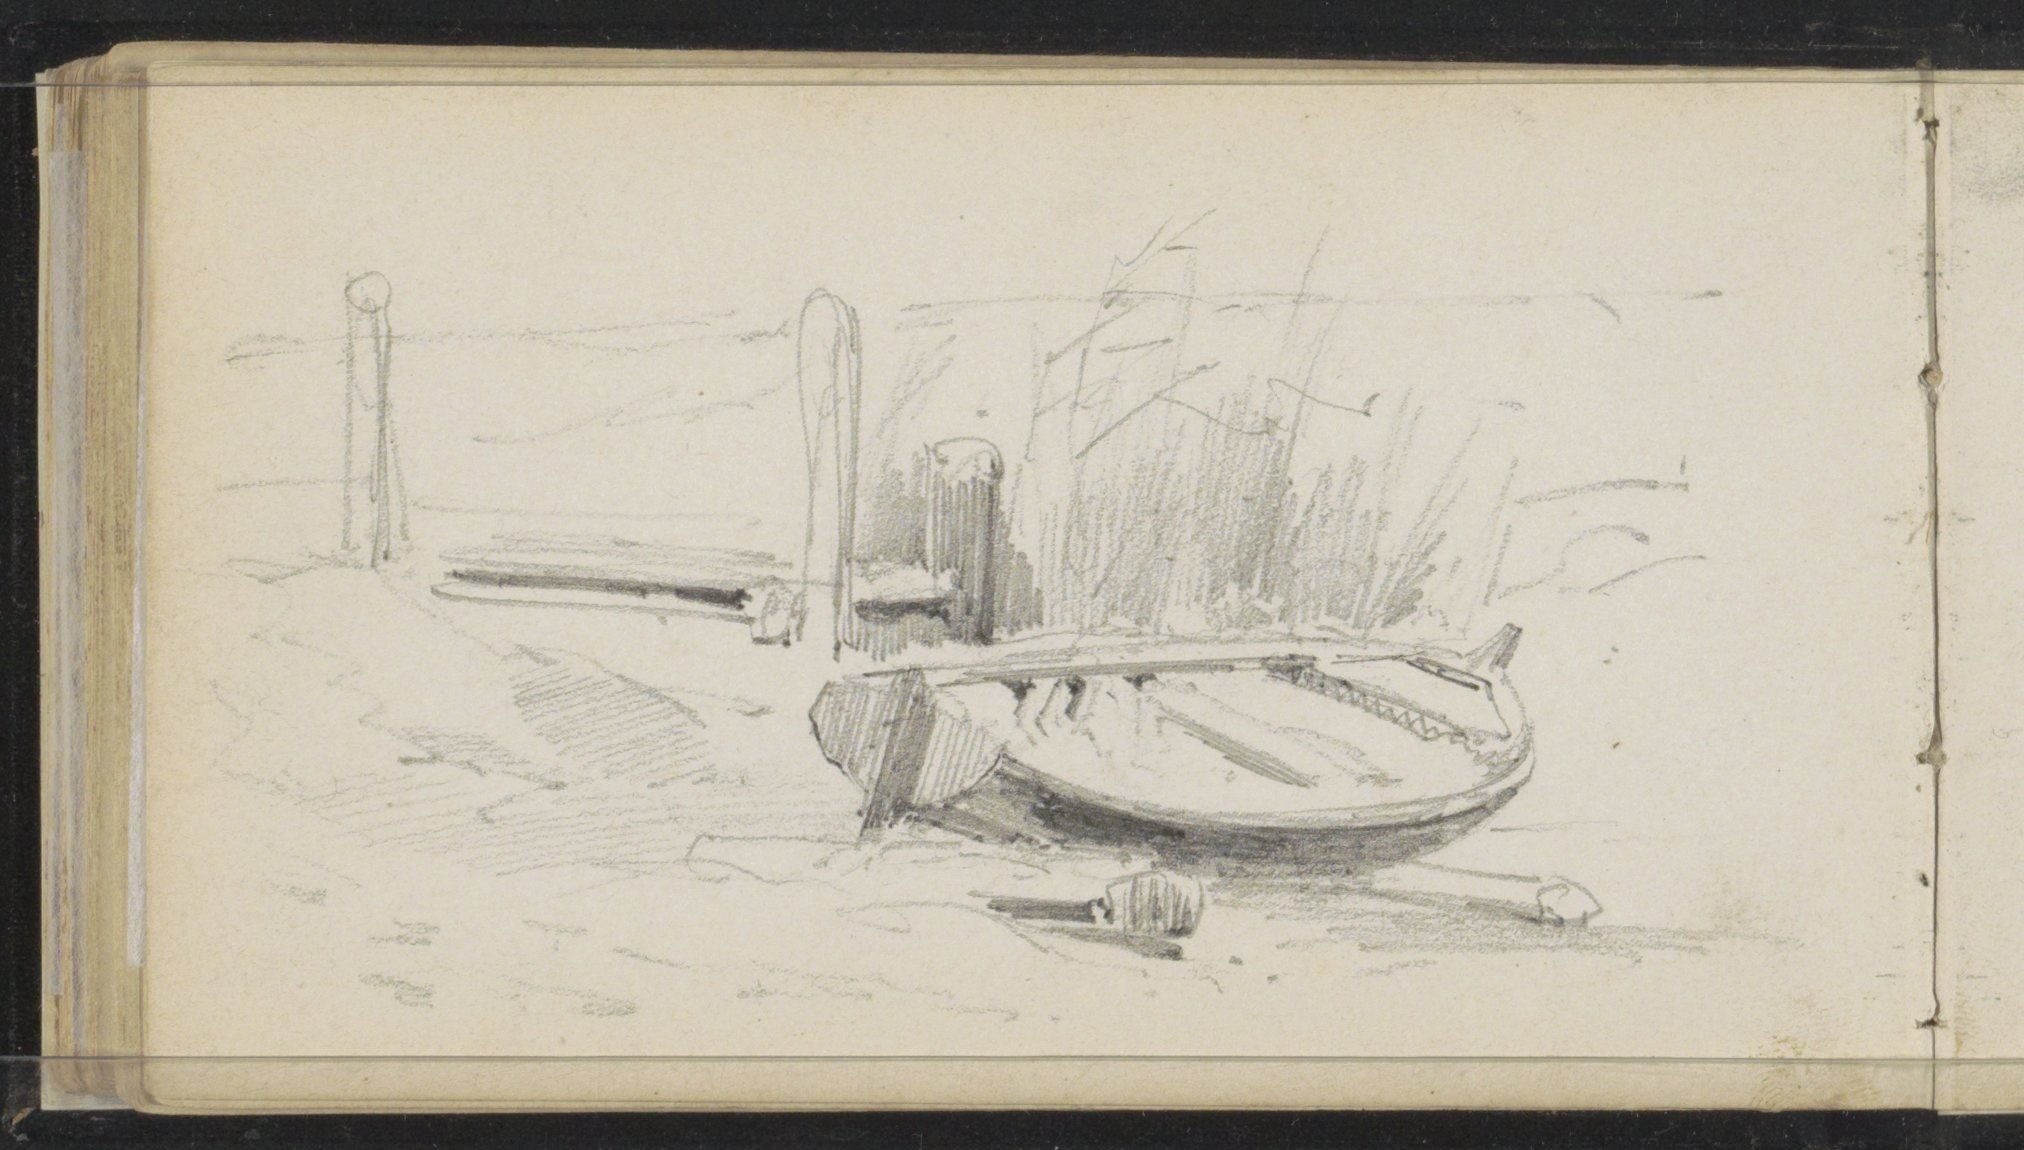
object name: sketchbook leaf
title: Roeiboot op het droge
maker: cornelis springer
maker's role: draughtsman, painter, print maker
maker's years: 1817-1891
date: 1860-1866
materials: paper, pencil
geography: netherlands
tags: landscapes with waters, waterscapes, seascapes (in the temperate zone), rowing-boat, canoe, etc.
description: Aan de rand van het water ligt een roeiboot op het droge. Blad 42 verso uit een schetsboek met 44 bladen.